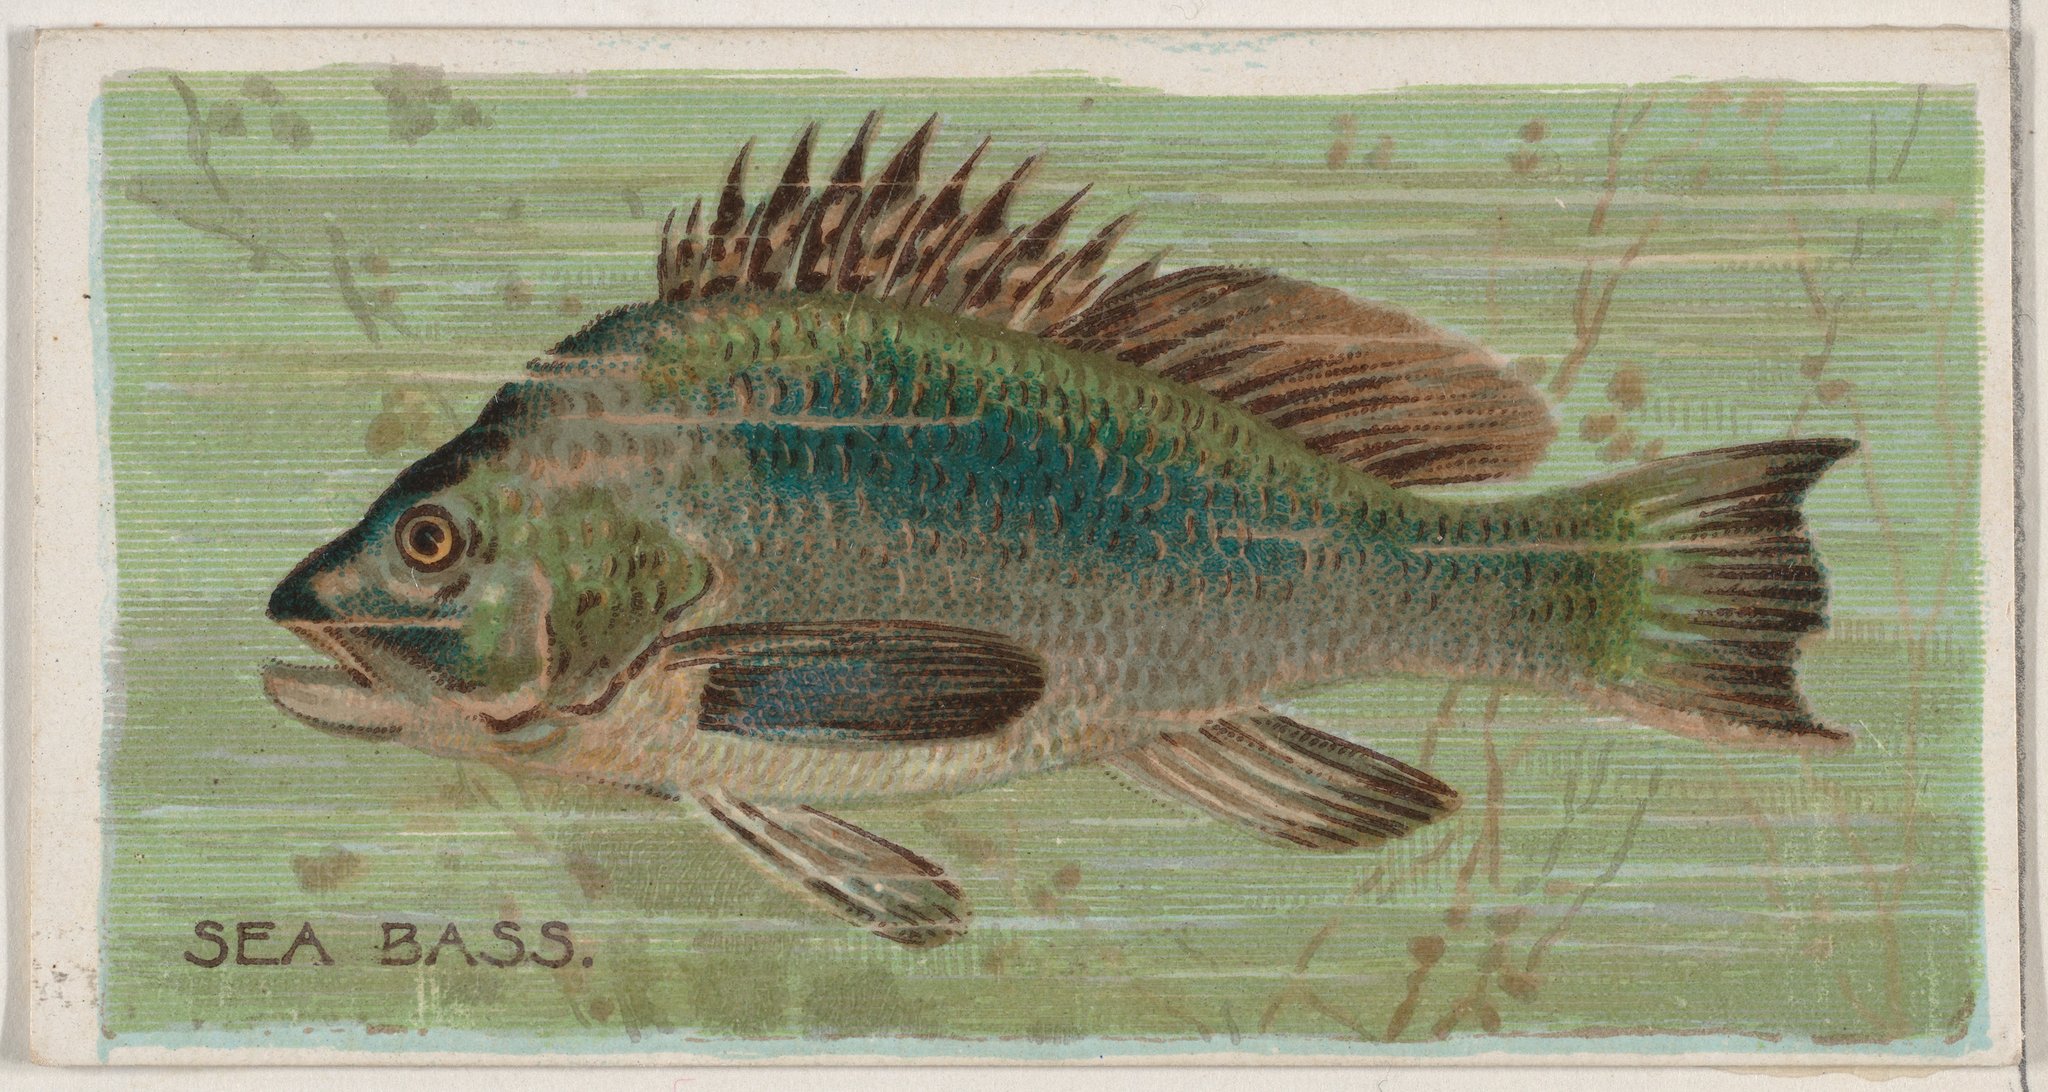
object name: print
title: Sea Bass, from the series Fishers and Fish (N74) for Duke brand cigarettes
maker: knapp & company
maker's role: lithographer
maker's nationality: american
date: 1888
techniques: color lithograph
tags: fish